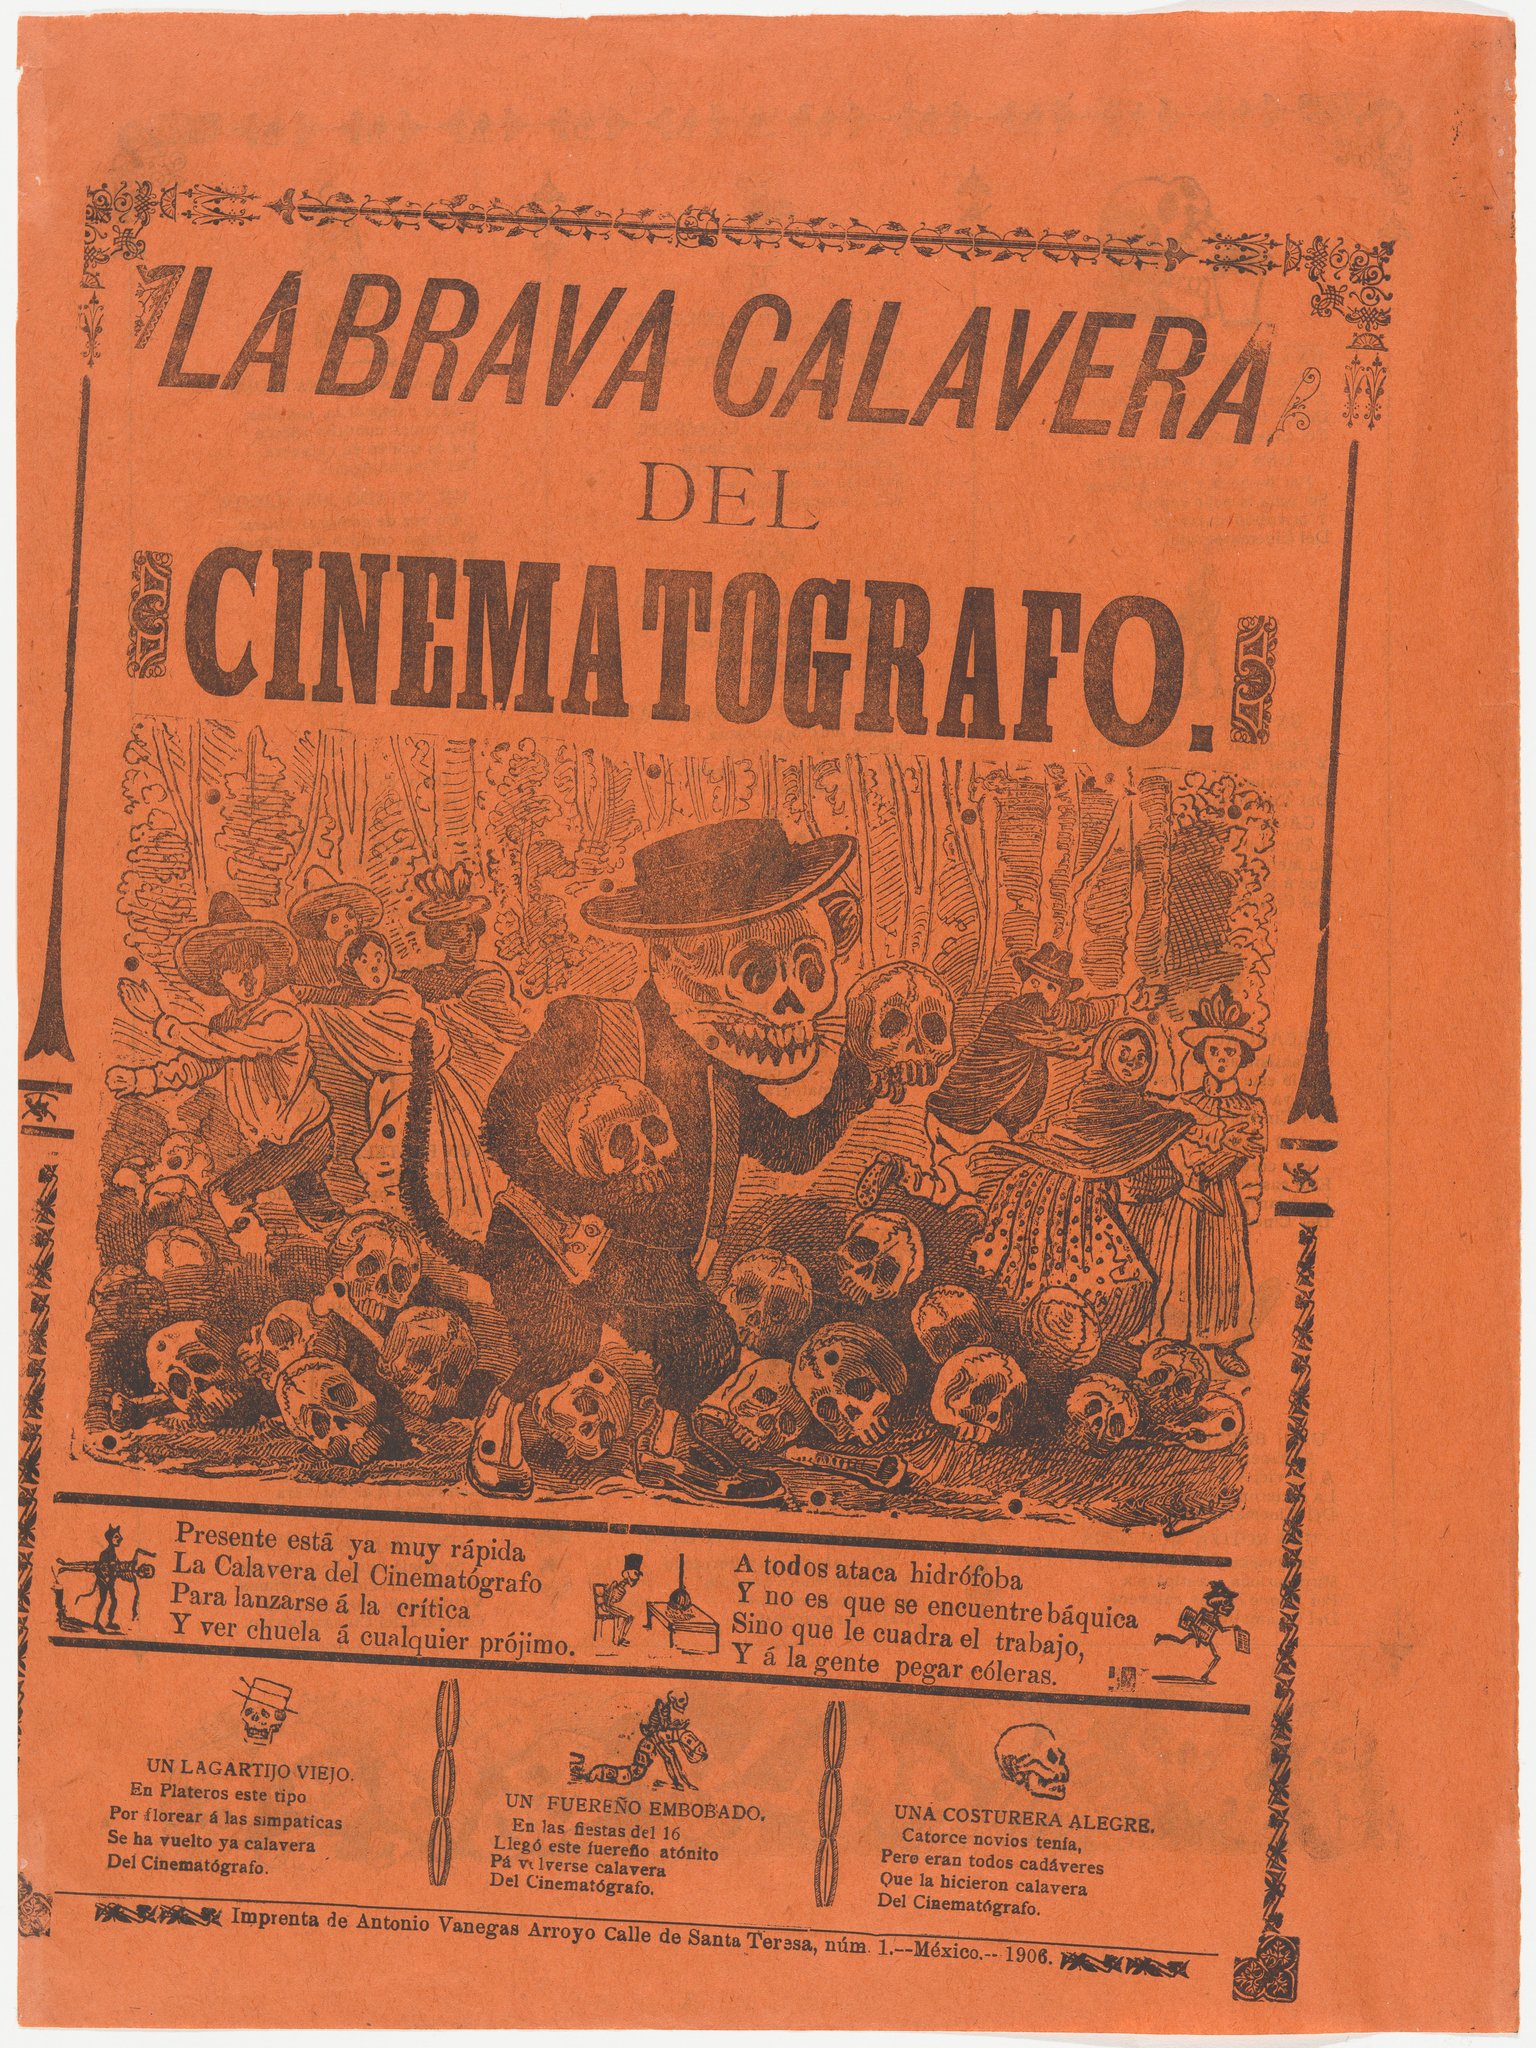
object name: print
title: The brave cinematographer skeleton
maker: josé guadalupe posada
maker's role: artist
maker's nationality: mexican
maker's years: 1852-1913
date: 1906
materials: paper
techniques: letterpress, printing, lithography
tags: skeletons